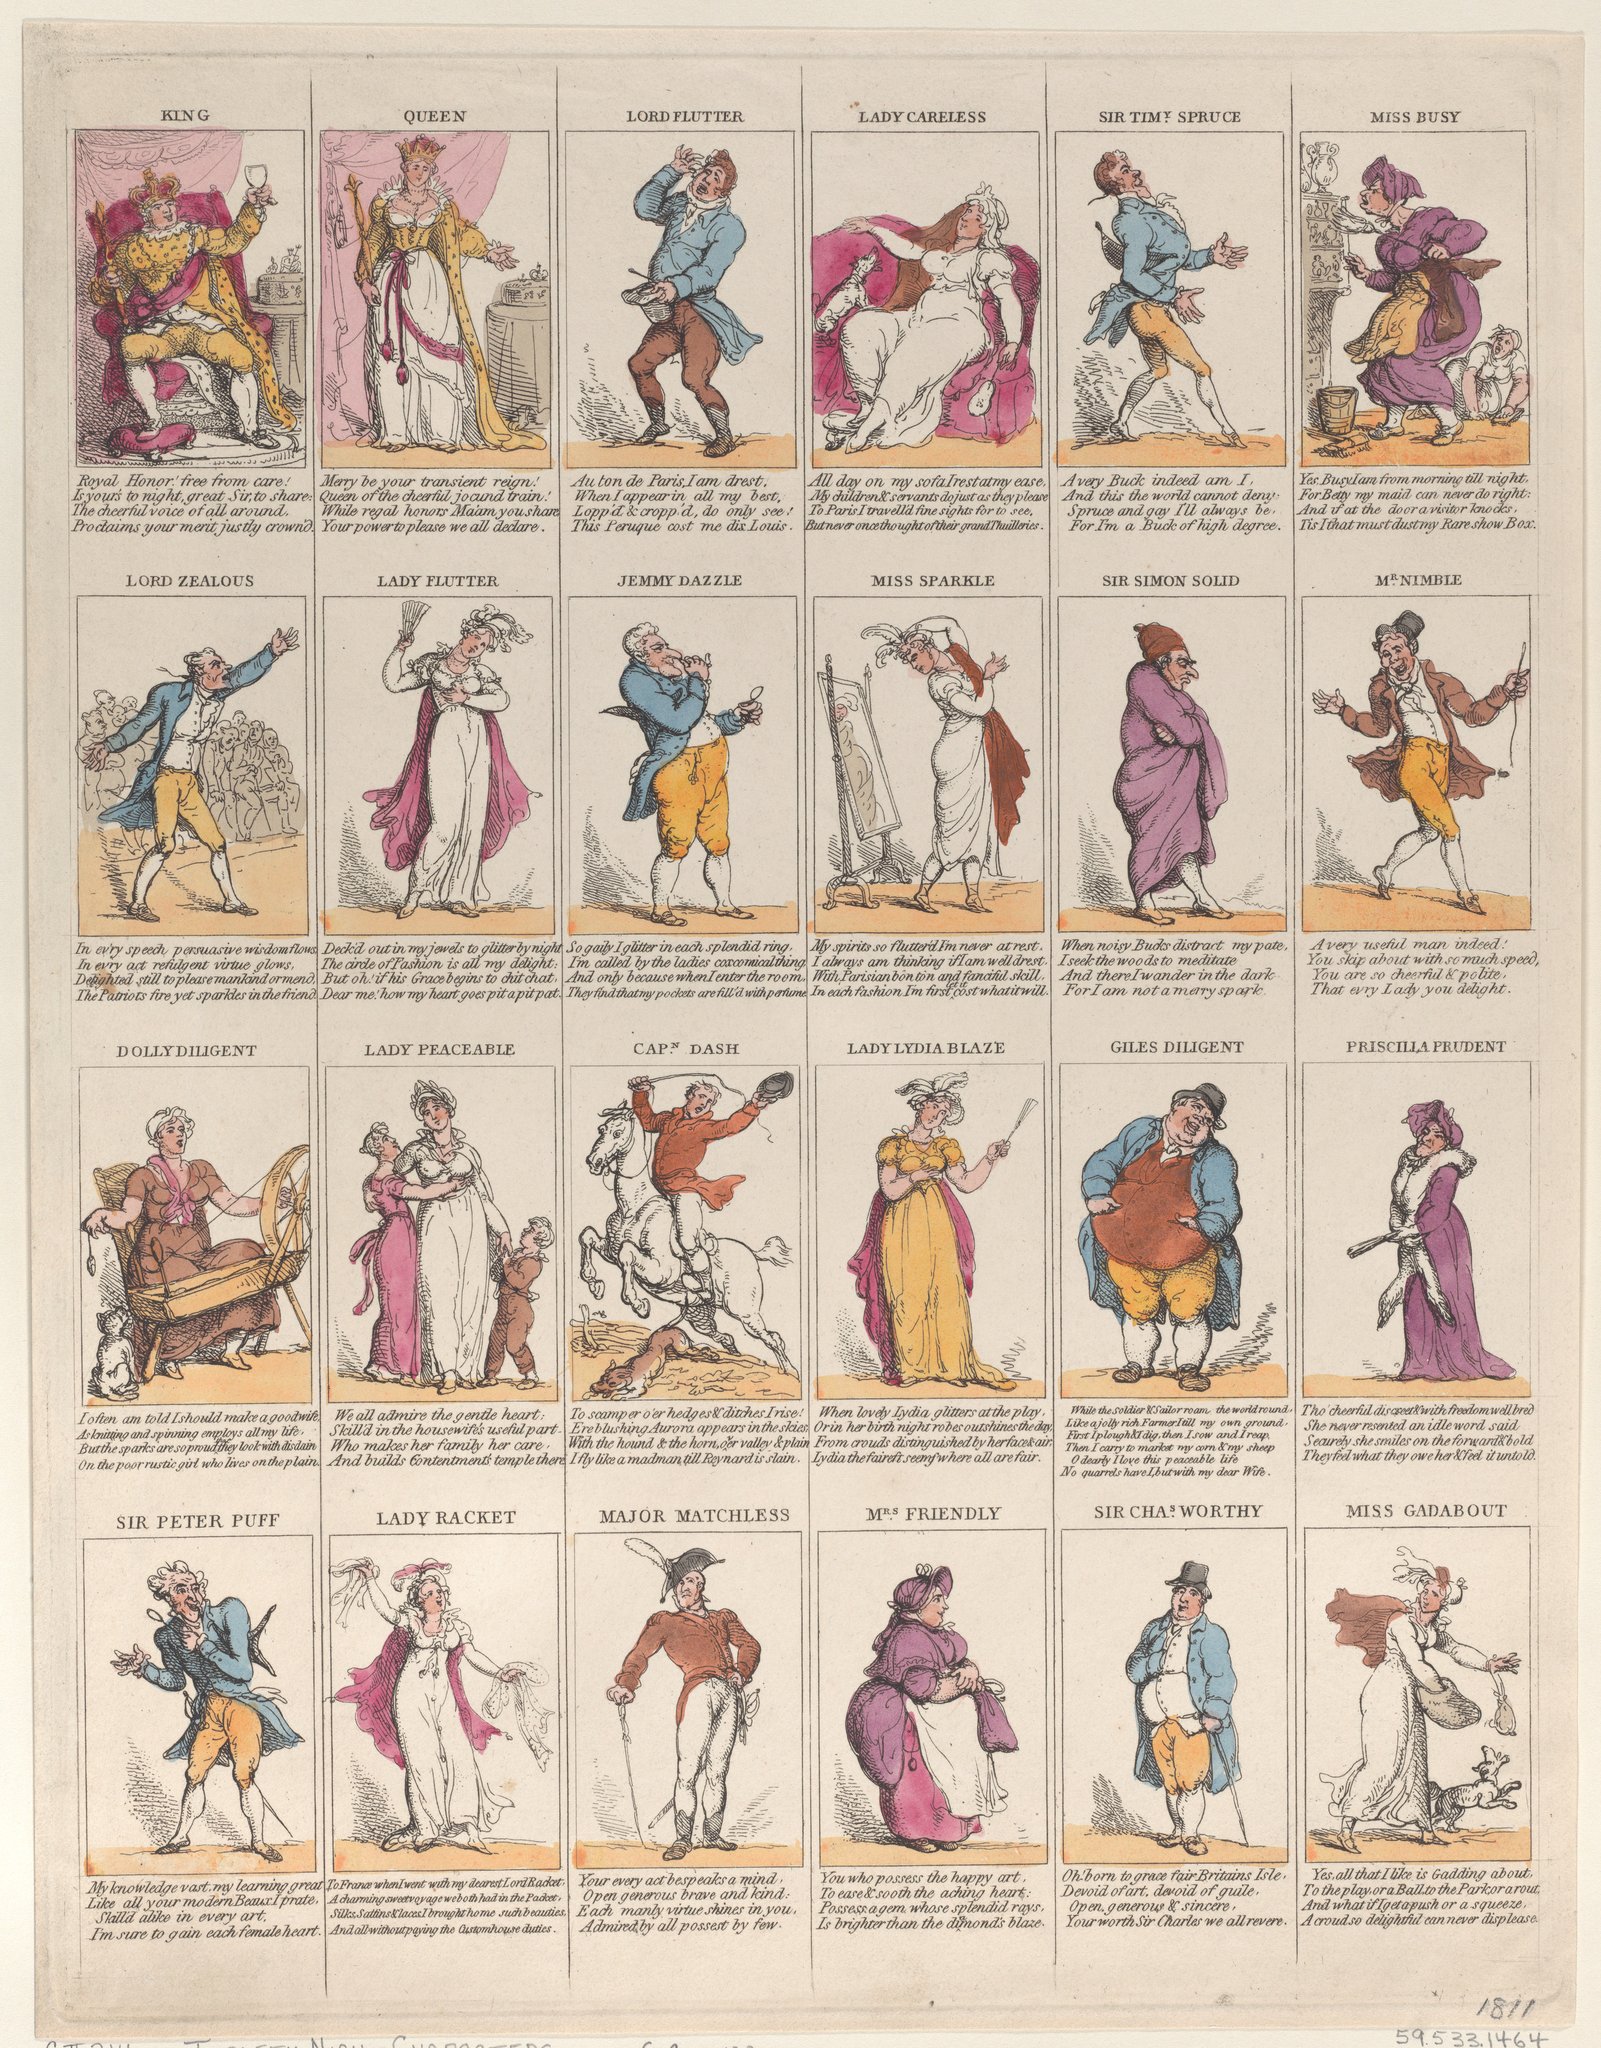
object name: print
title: Twelfth Night Characters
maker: thomas rowlandson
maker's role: artist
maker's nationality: british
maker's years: 1757-1827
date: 1811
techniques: etching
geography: london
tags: satire,men,women